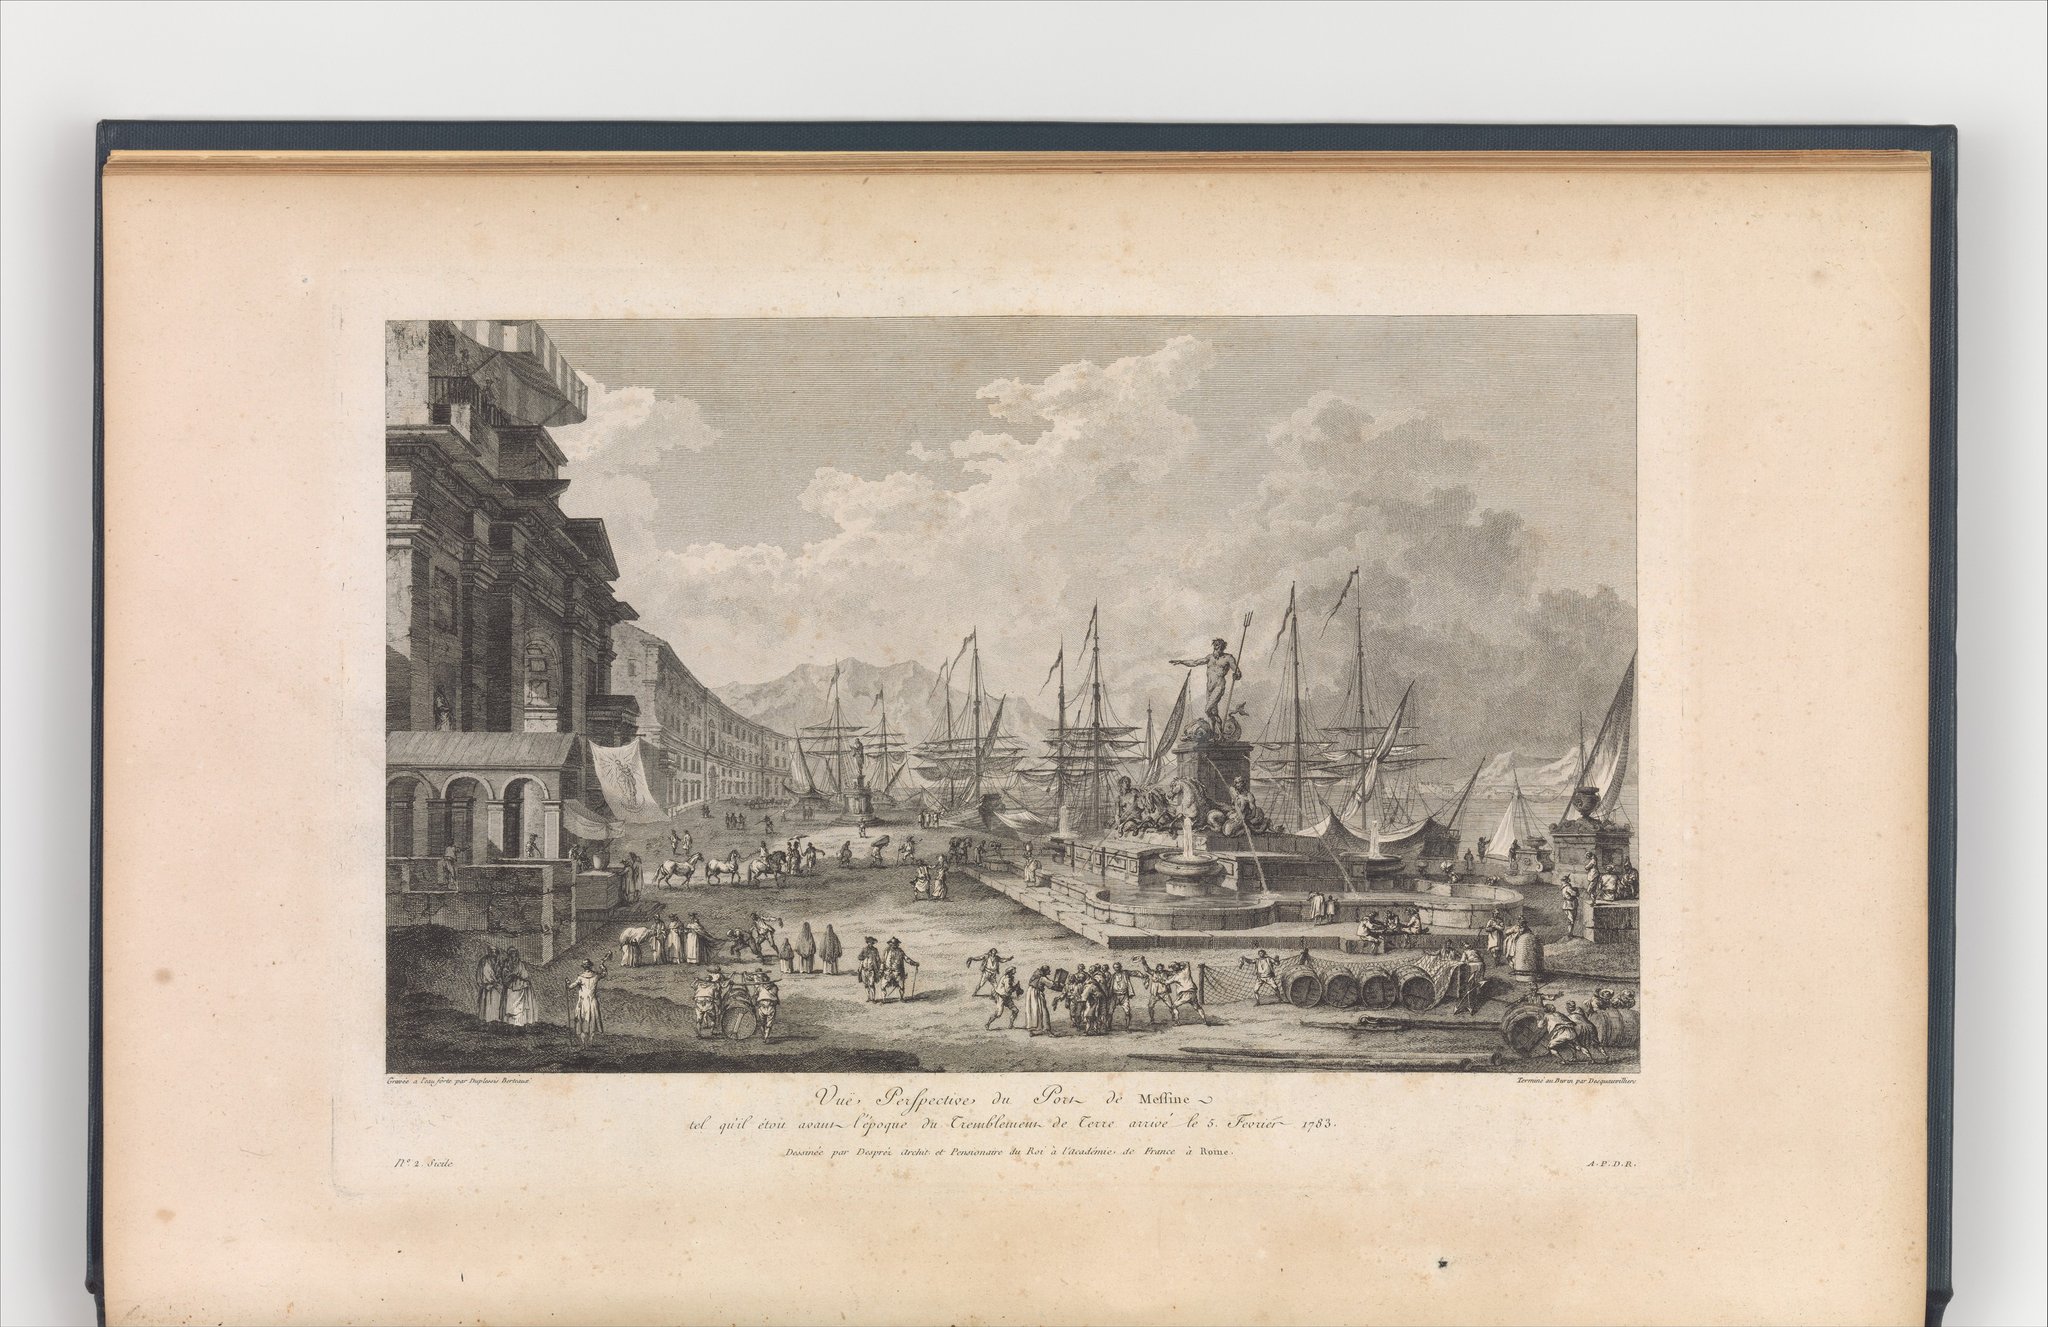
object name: book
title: Voyages Pittoresque ou, Description des royaumes de Naples et de Sicile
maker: jean claude richard, abbé de saint-non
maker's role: author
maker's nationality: french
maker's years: 1727-1791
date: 1781-1786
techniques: engraving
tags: buildings,crowd